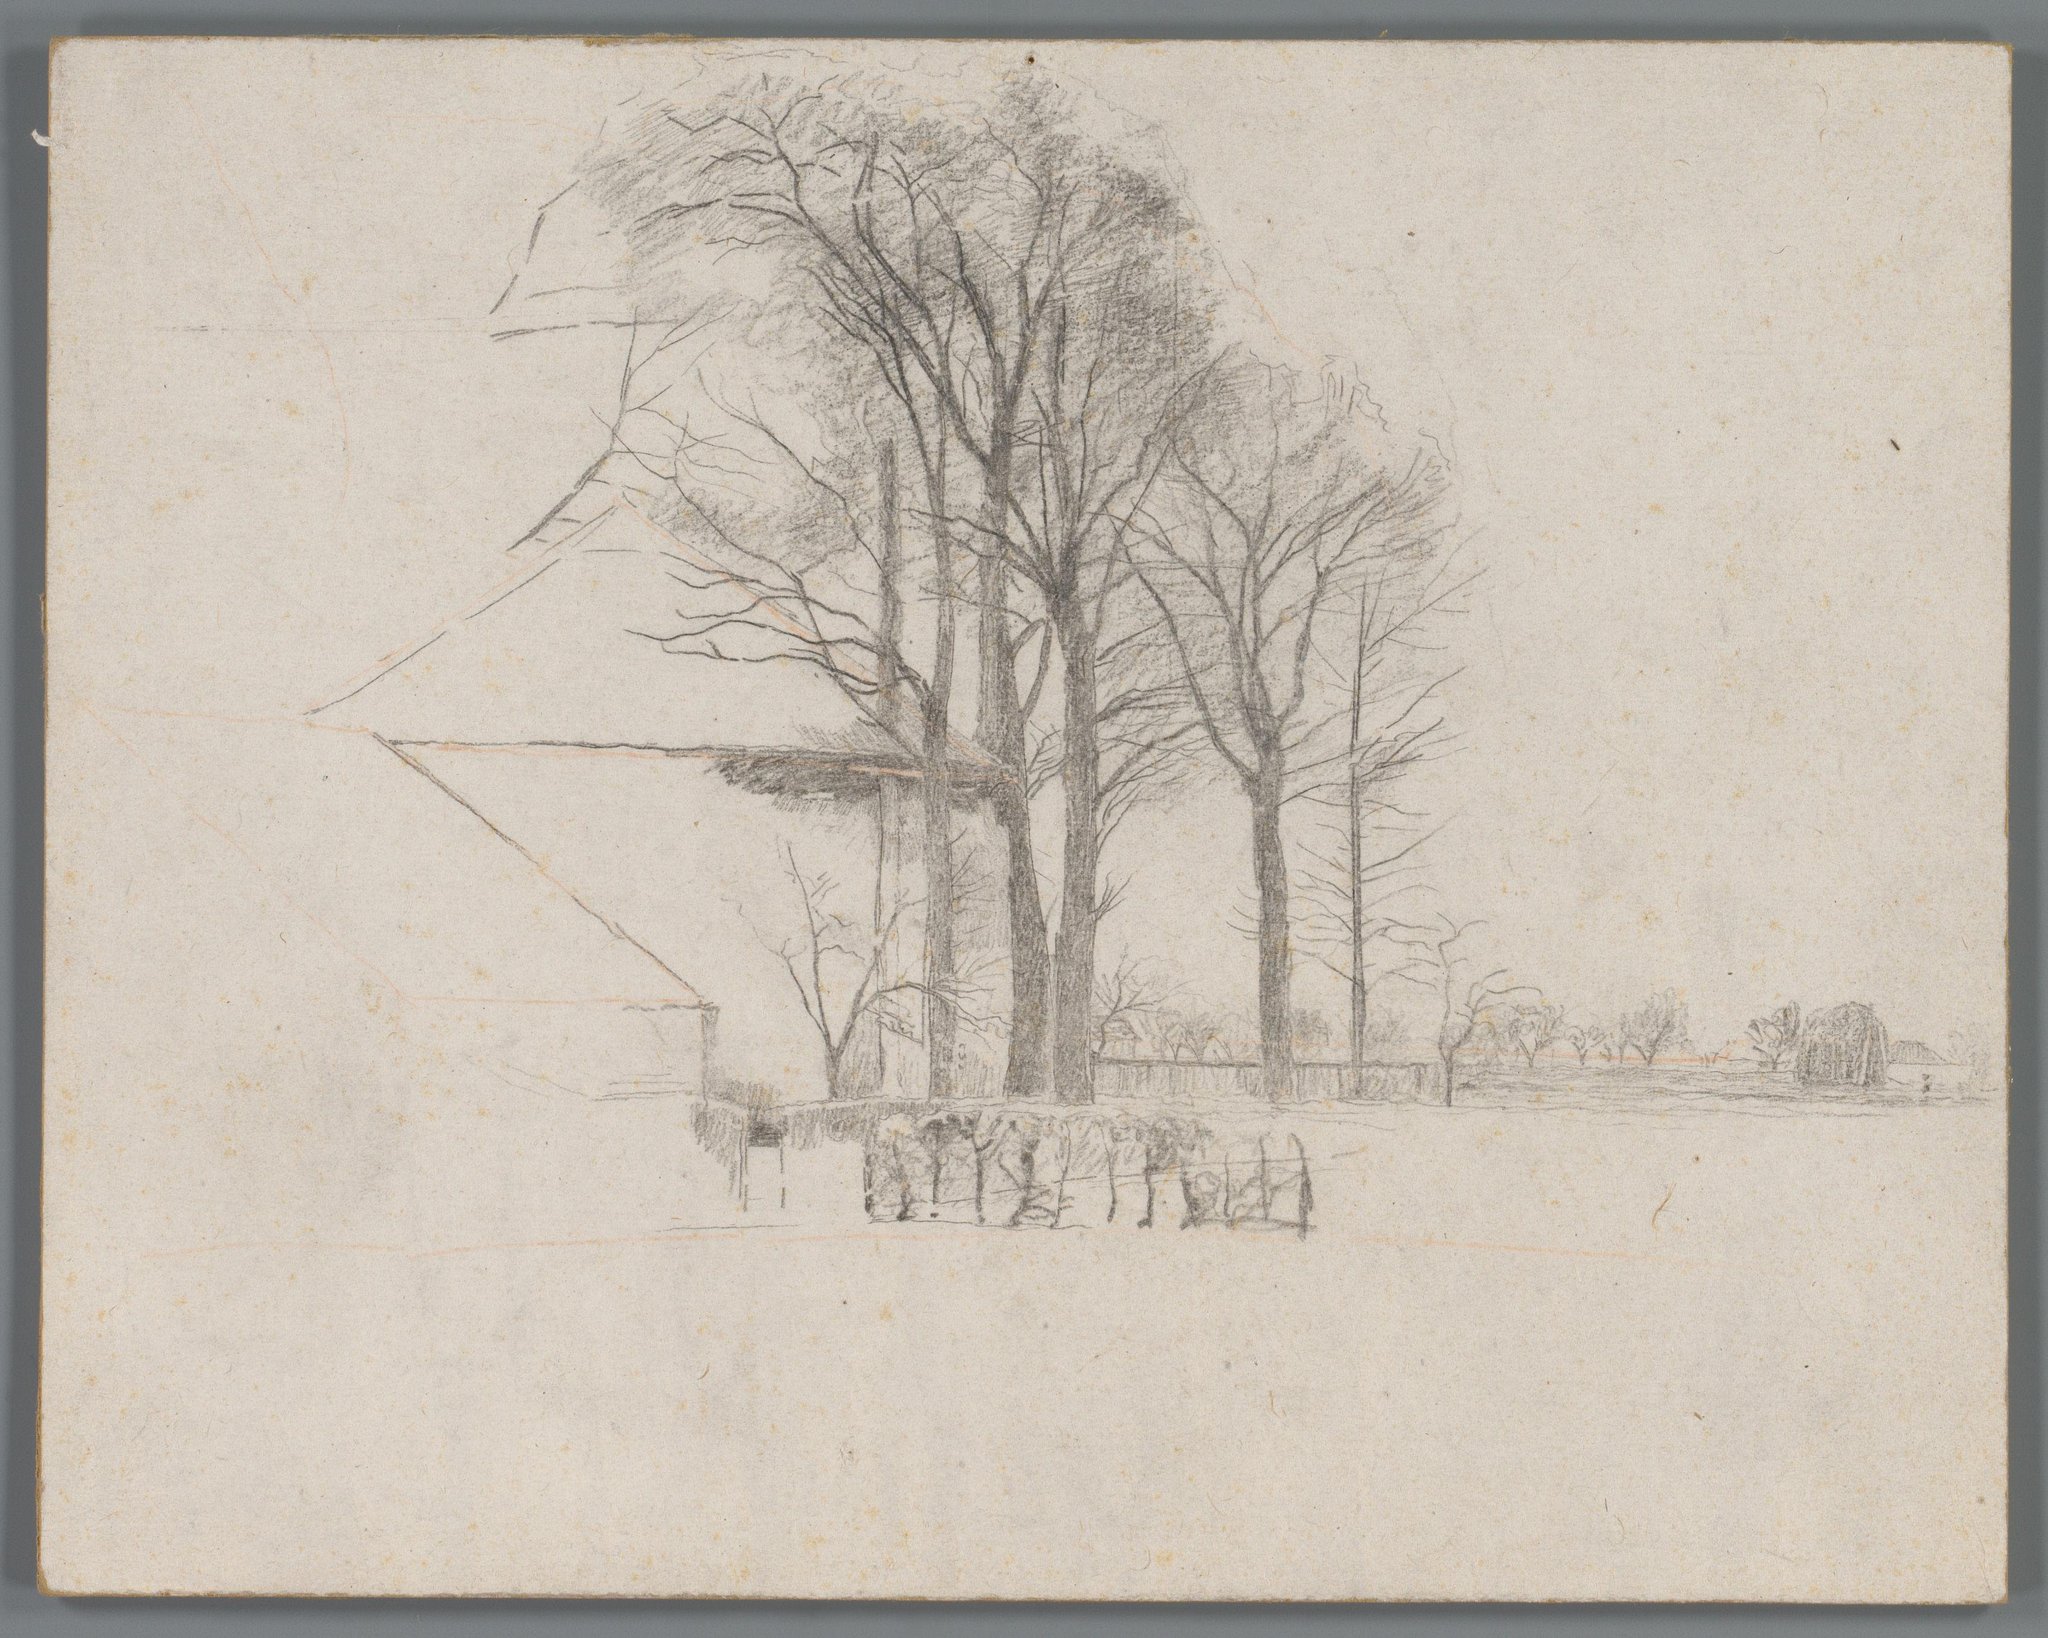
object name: drawing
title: Gezicht op een hooischuur en bomen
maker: gerrit willem dijsselhof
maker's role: designer, draughtsman, print maker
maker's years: 1866-1924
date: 1876-1924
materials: cardboard, chalk, paper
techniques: pasting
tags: barn, trees